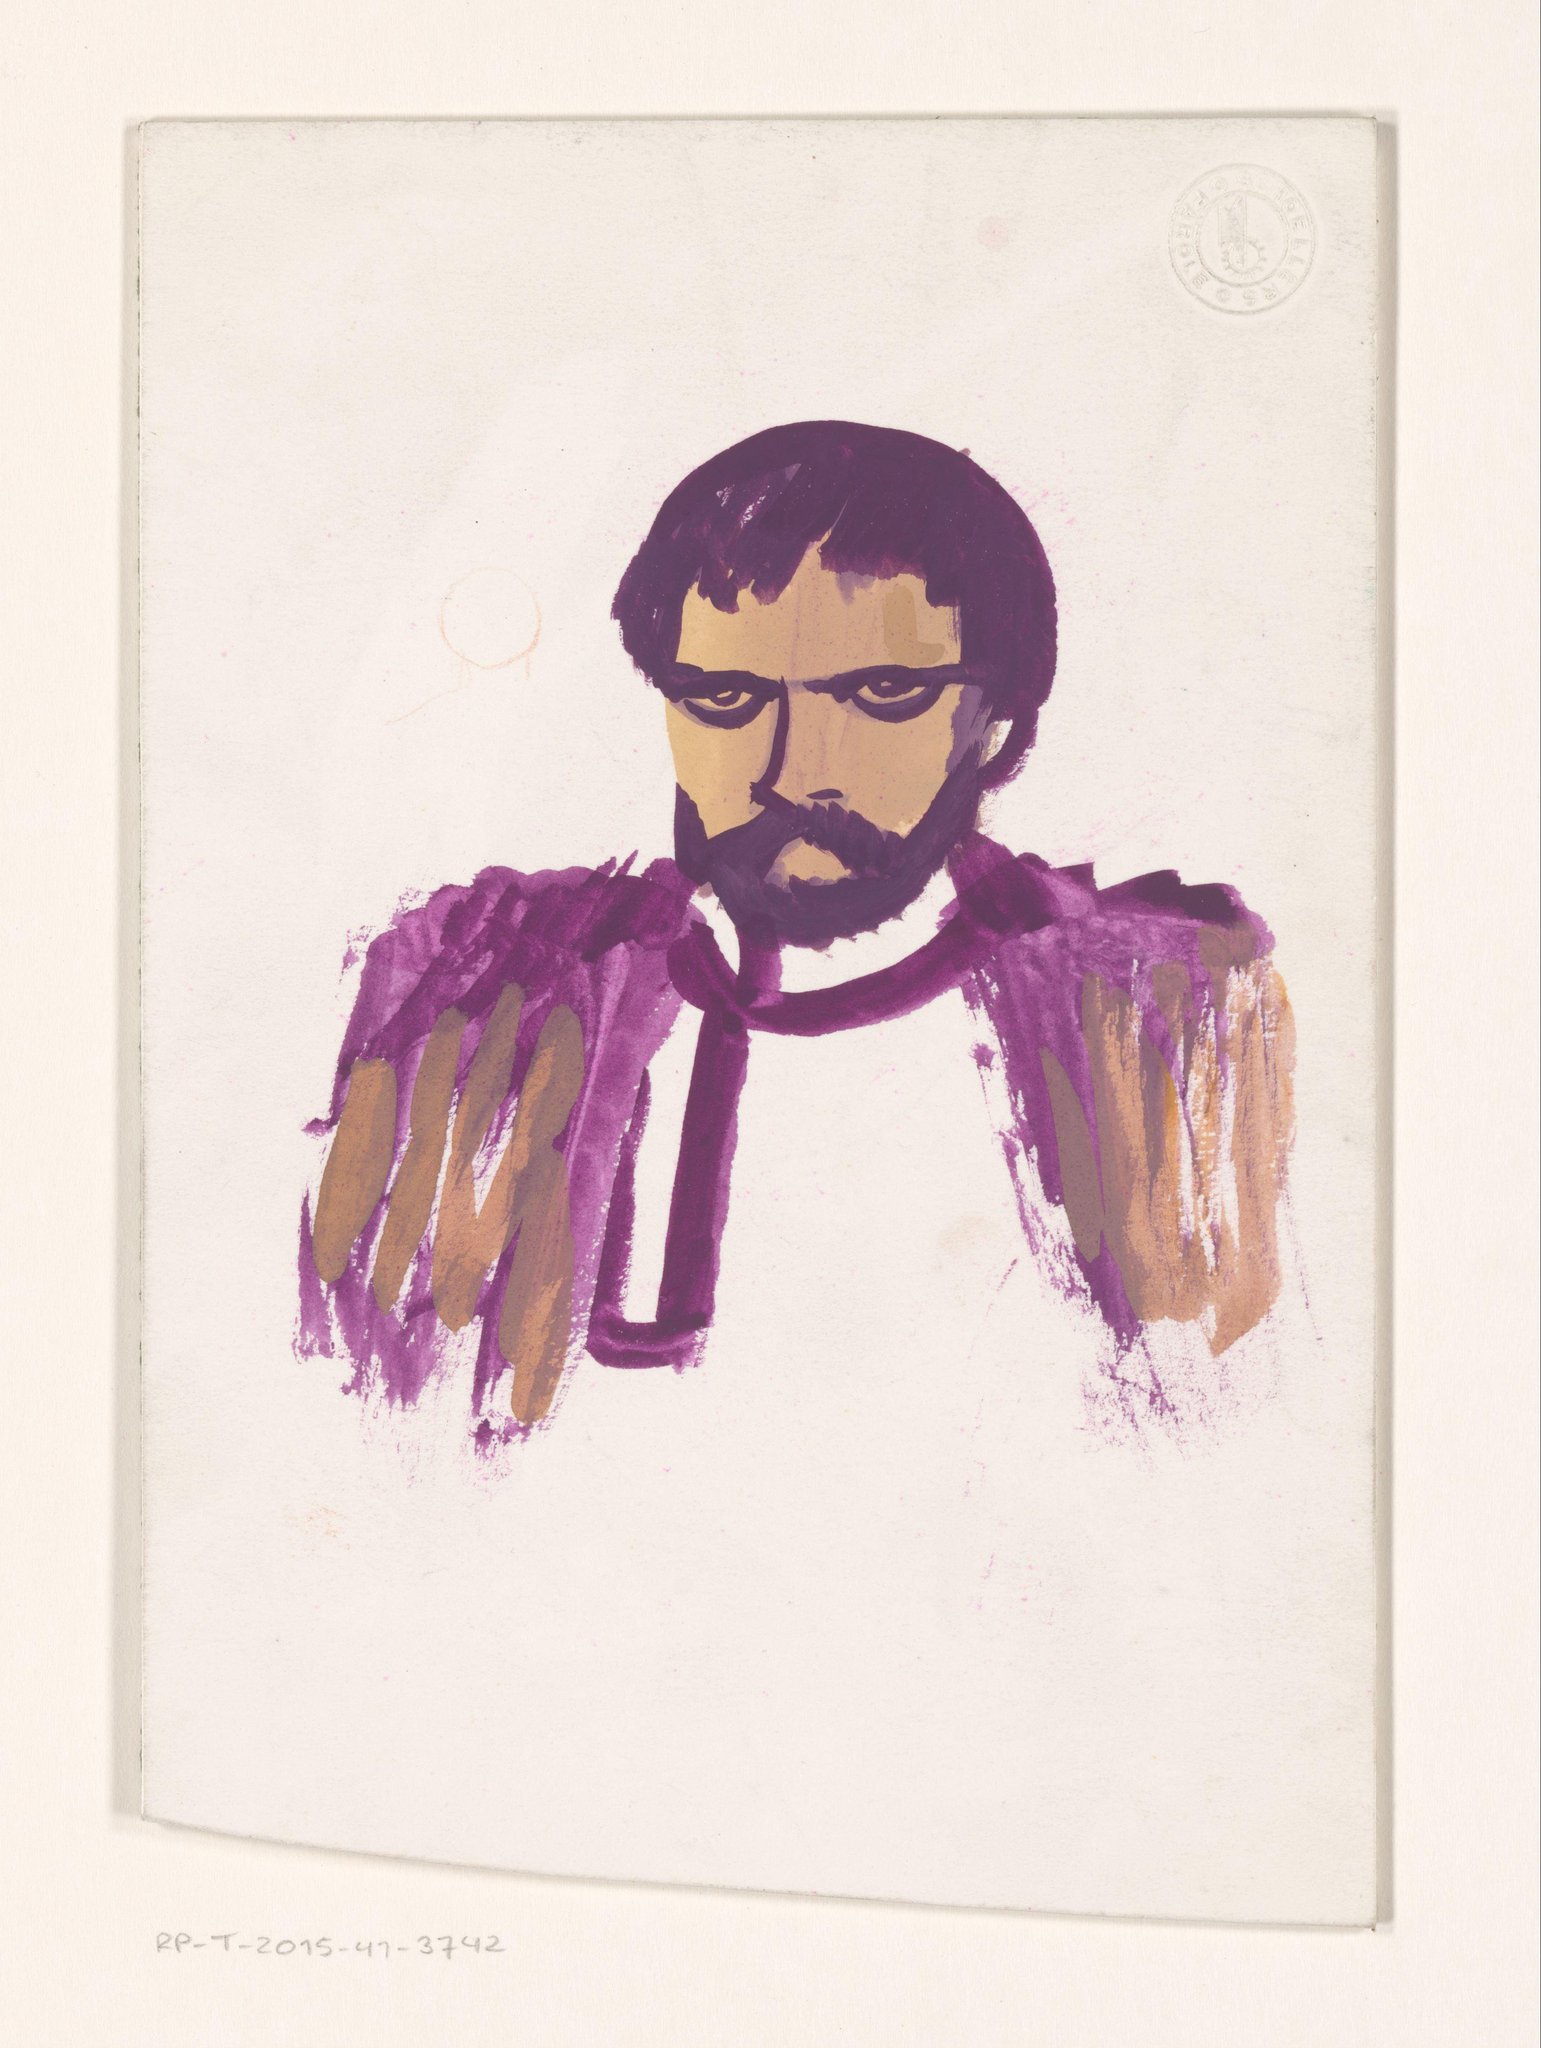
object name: drawing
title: Bandontwerp voor: N.S. Ljeskow, De onsterfelijke, 1965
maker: karel thole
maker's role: painter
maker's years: 1914-2000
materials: cardboard, paint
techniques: brush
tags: coat, beard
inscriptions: collector's mark: Lugt 2228a, check stamp: ‘SCHOELLERS PAROLE’